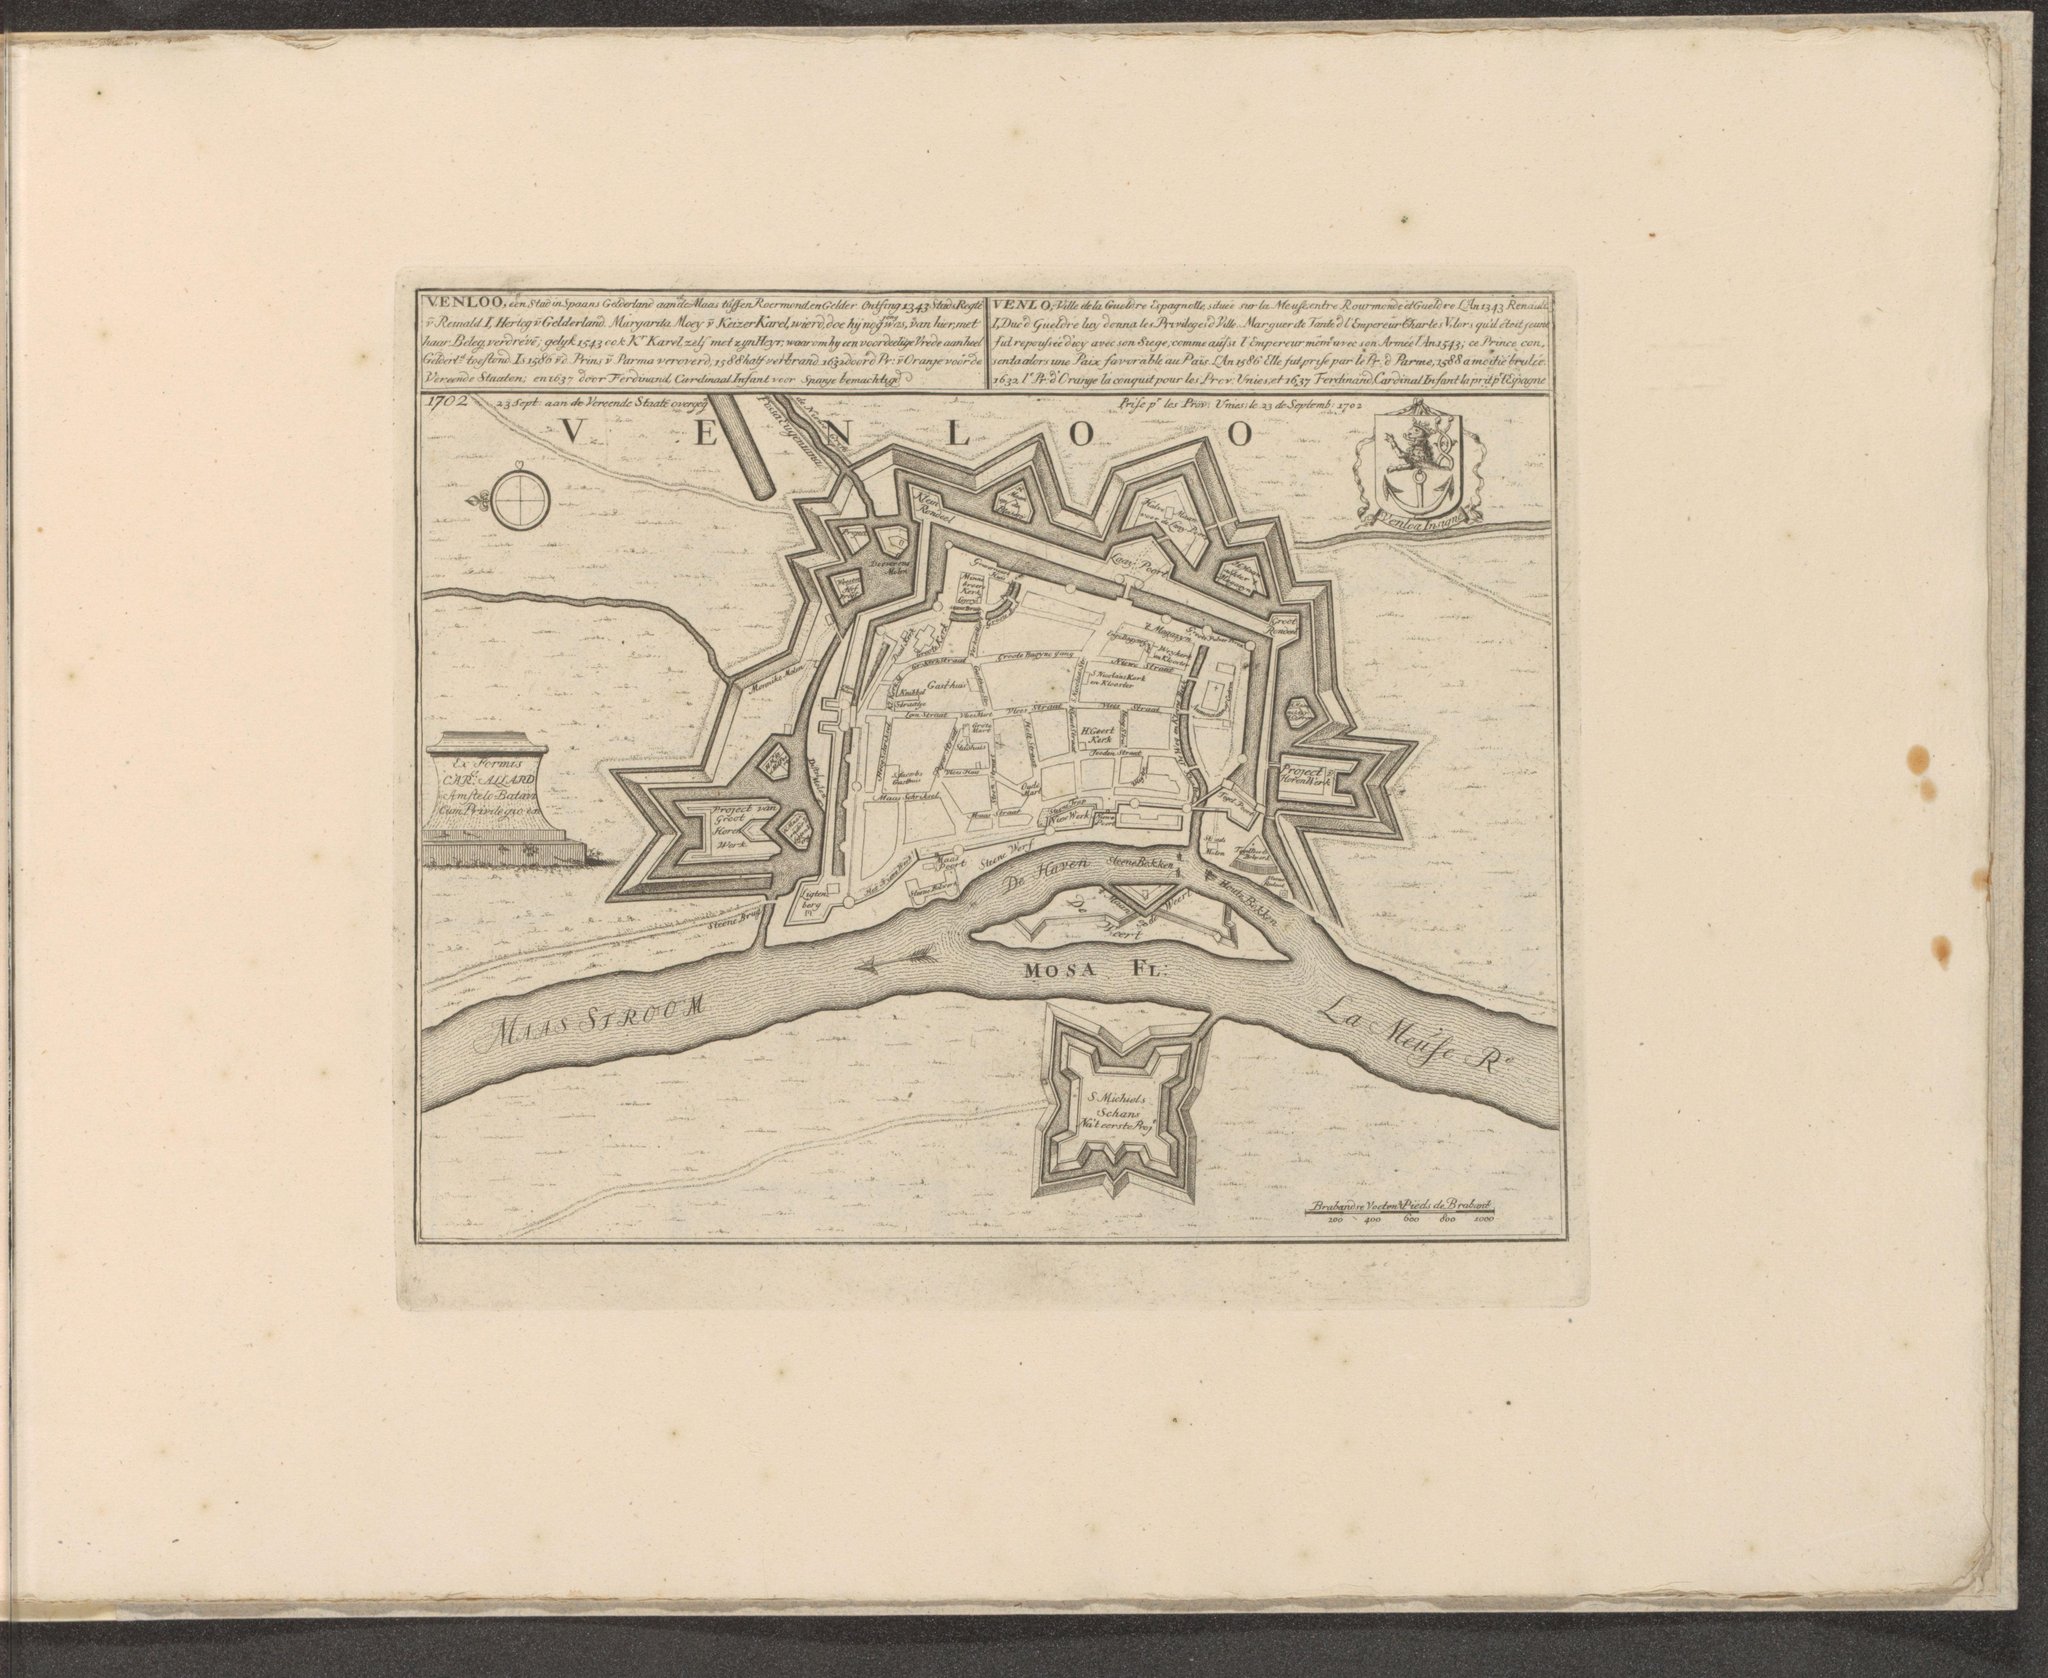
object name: album leaf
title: Plattegrond van Venlo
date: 1702-1733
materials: paper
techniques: etching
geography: amsterdam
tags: fortifications, military engineering, maps of cities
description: Plattegrond van de stad Venlo. Na beleg overgegaan naar de Verenigde Nederlanden, 23 september 1702. Met teksten in het Nederlands en Frans. De prent maakt deel uit van een album.